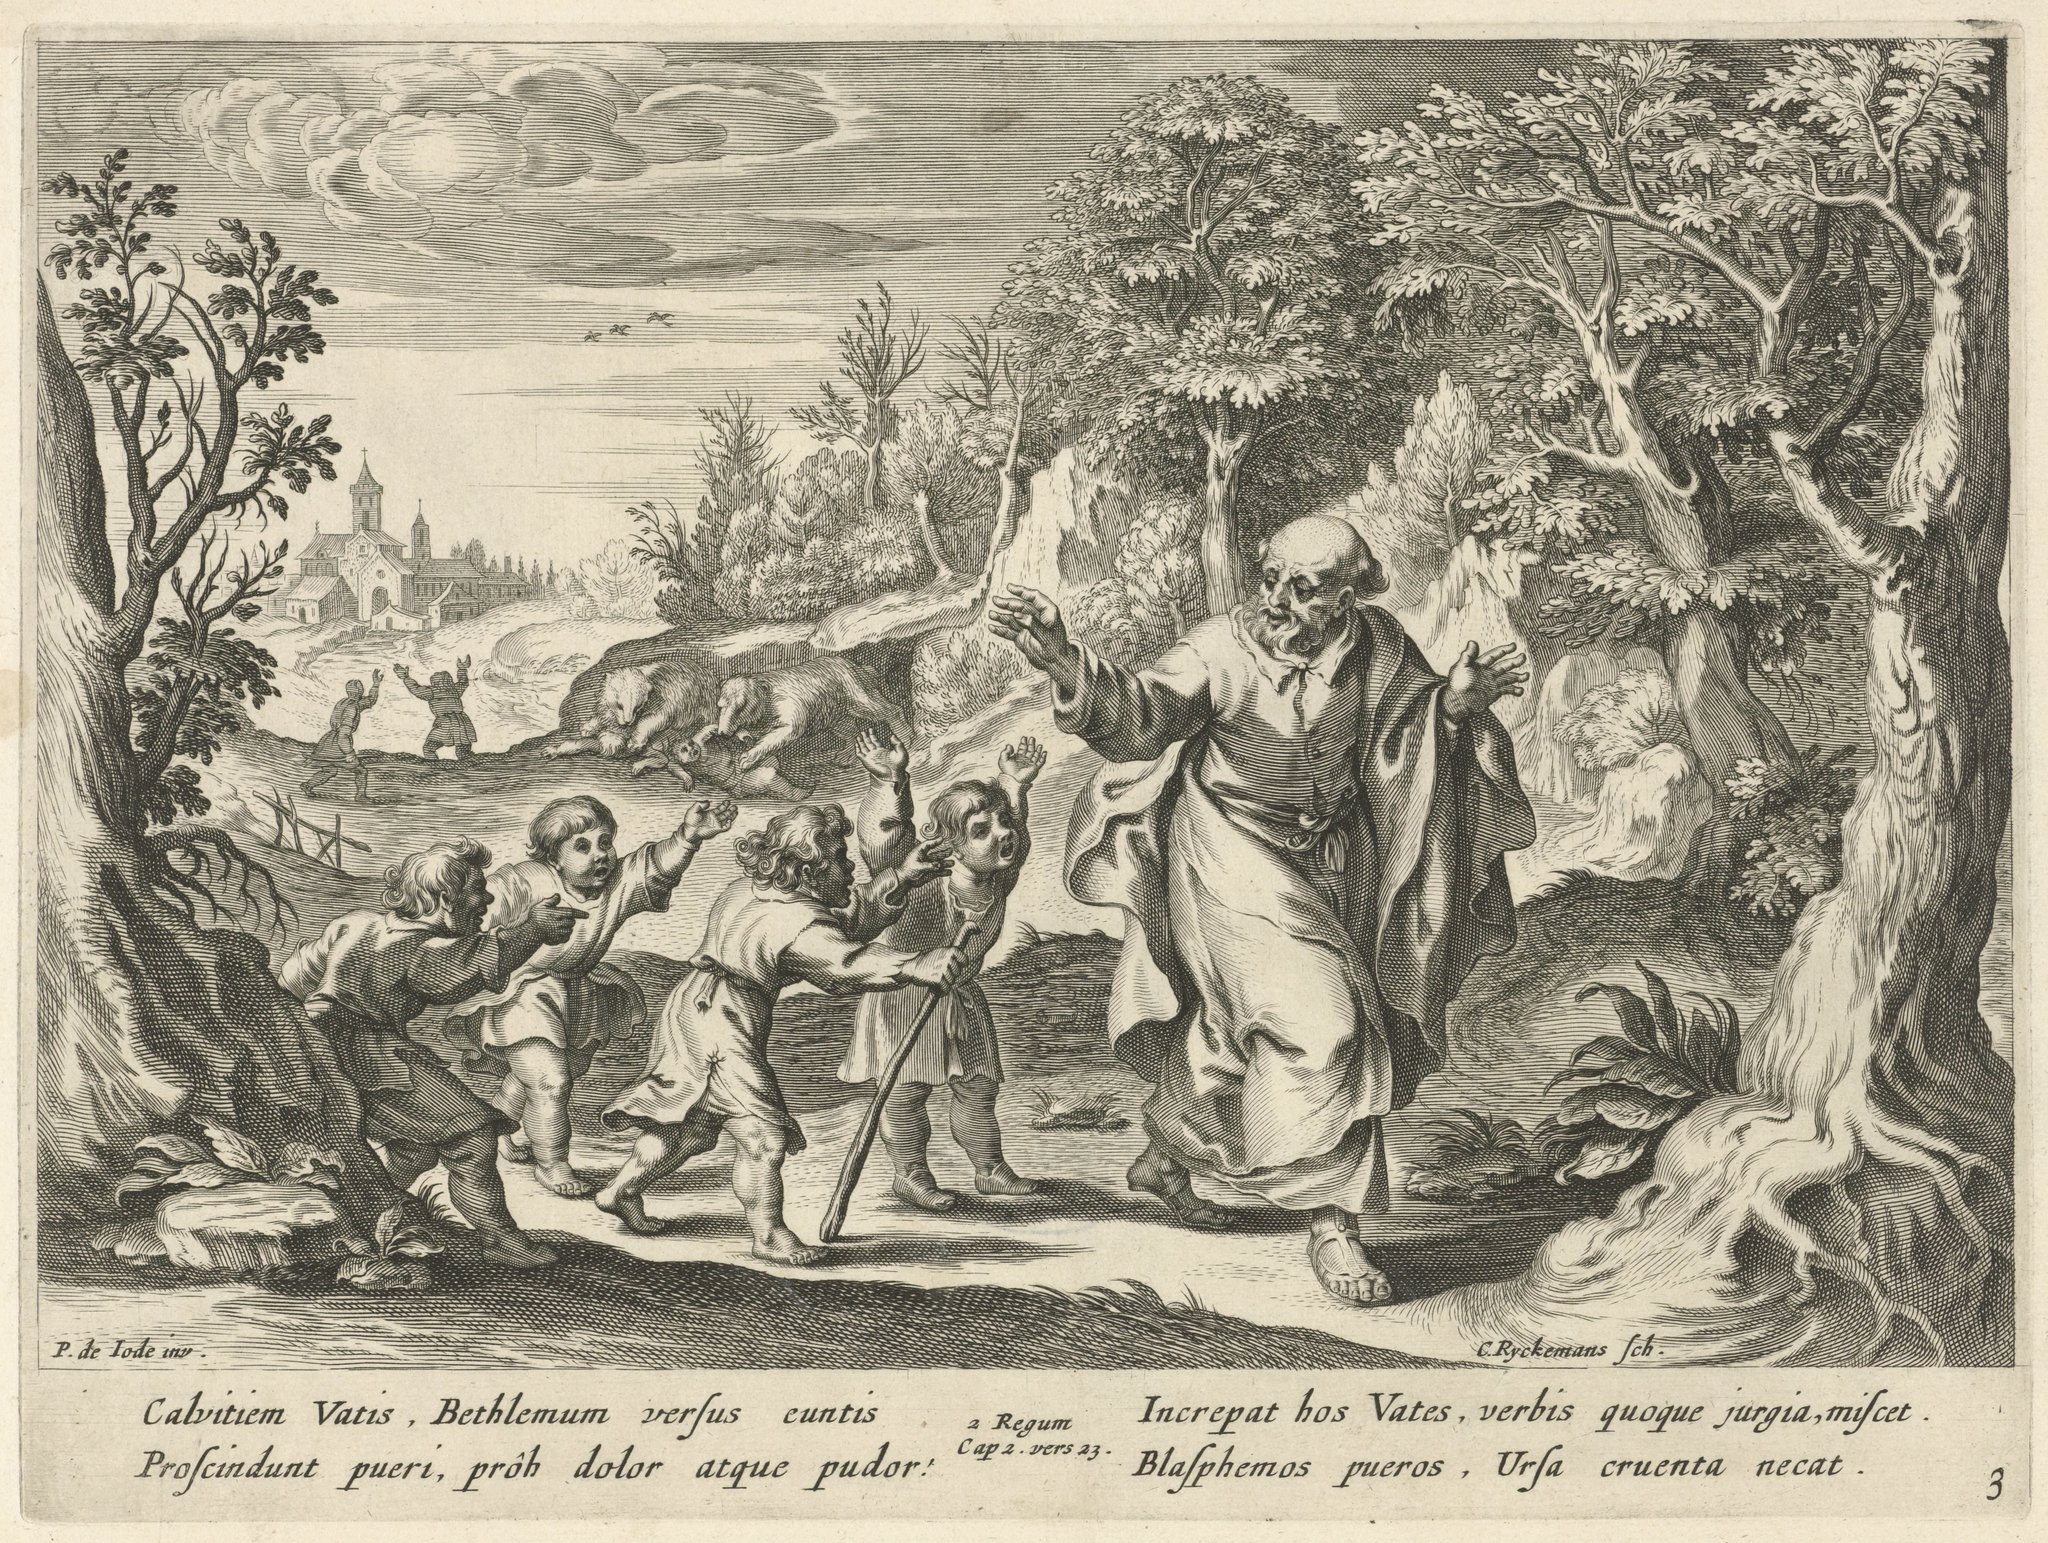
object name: print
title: Elisa door kinderen bespot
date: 1616-1636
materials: paper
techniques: engraving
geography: antwerp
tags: two bears come out of the woods and tear the children who were mocking elisha to pieces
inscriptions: collector's mark: Lugt 2228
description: Elisa wordt op weg naar Betel uitgescholden door kinderen voor kaalkop en hij vervloekt hen. Op de achtergrond is weergegeven hoe de kinderen door beren verslonden worden.